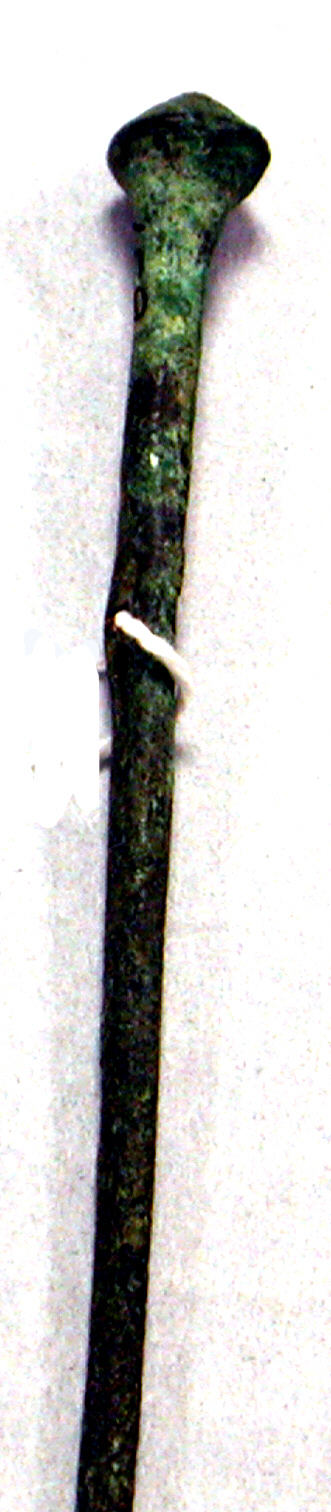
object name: pin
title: Pin (?)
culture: peruvian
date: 1-1566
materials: copper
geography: peru